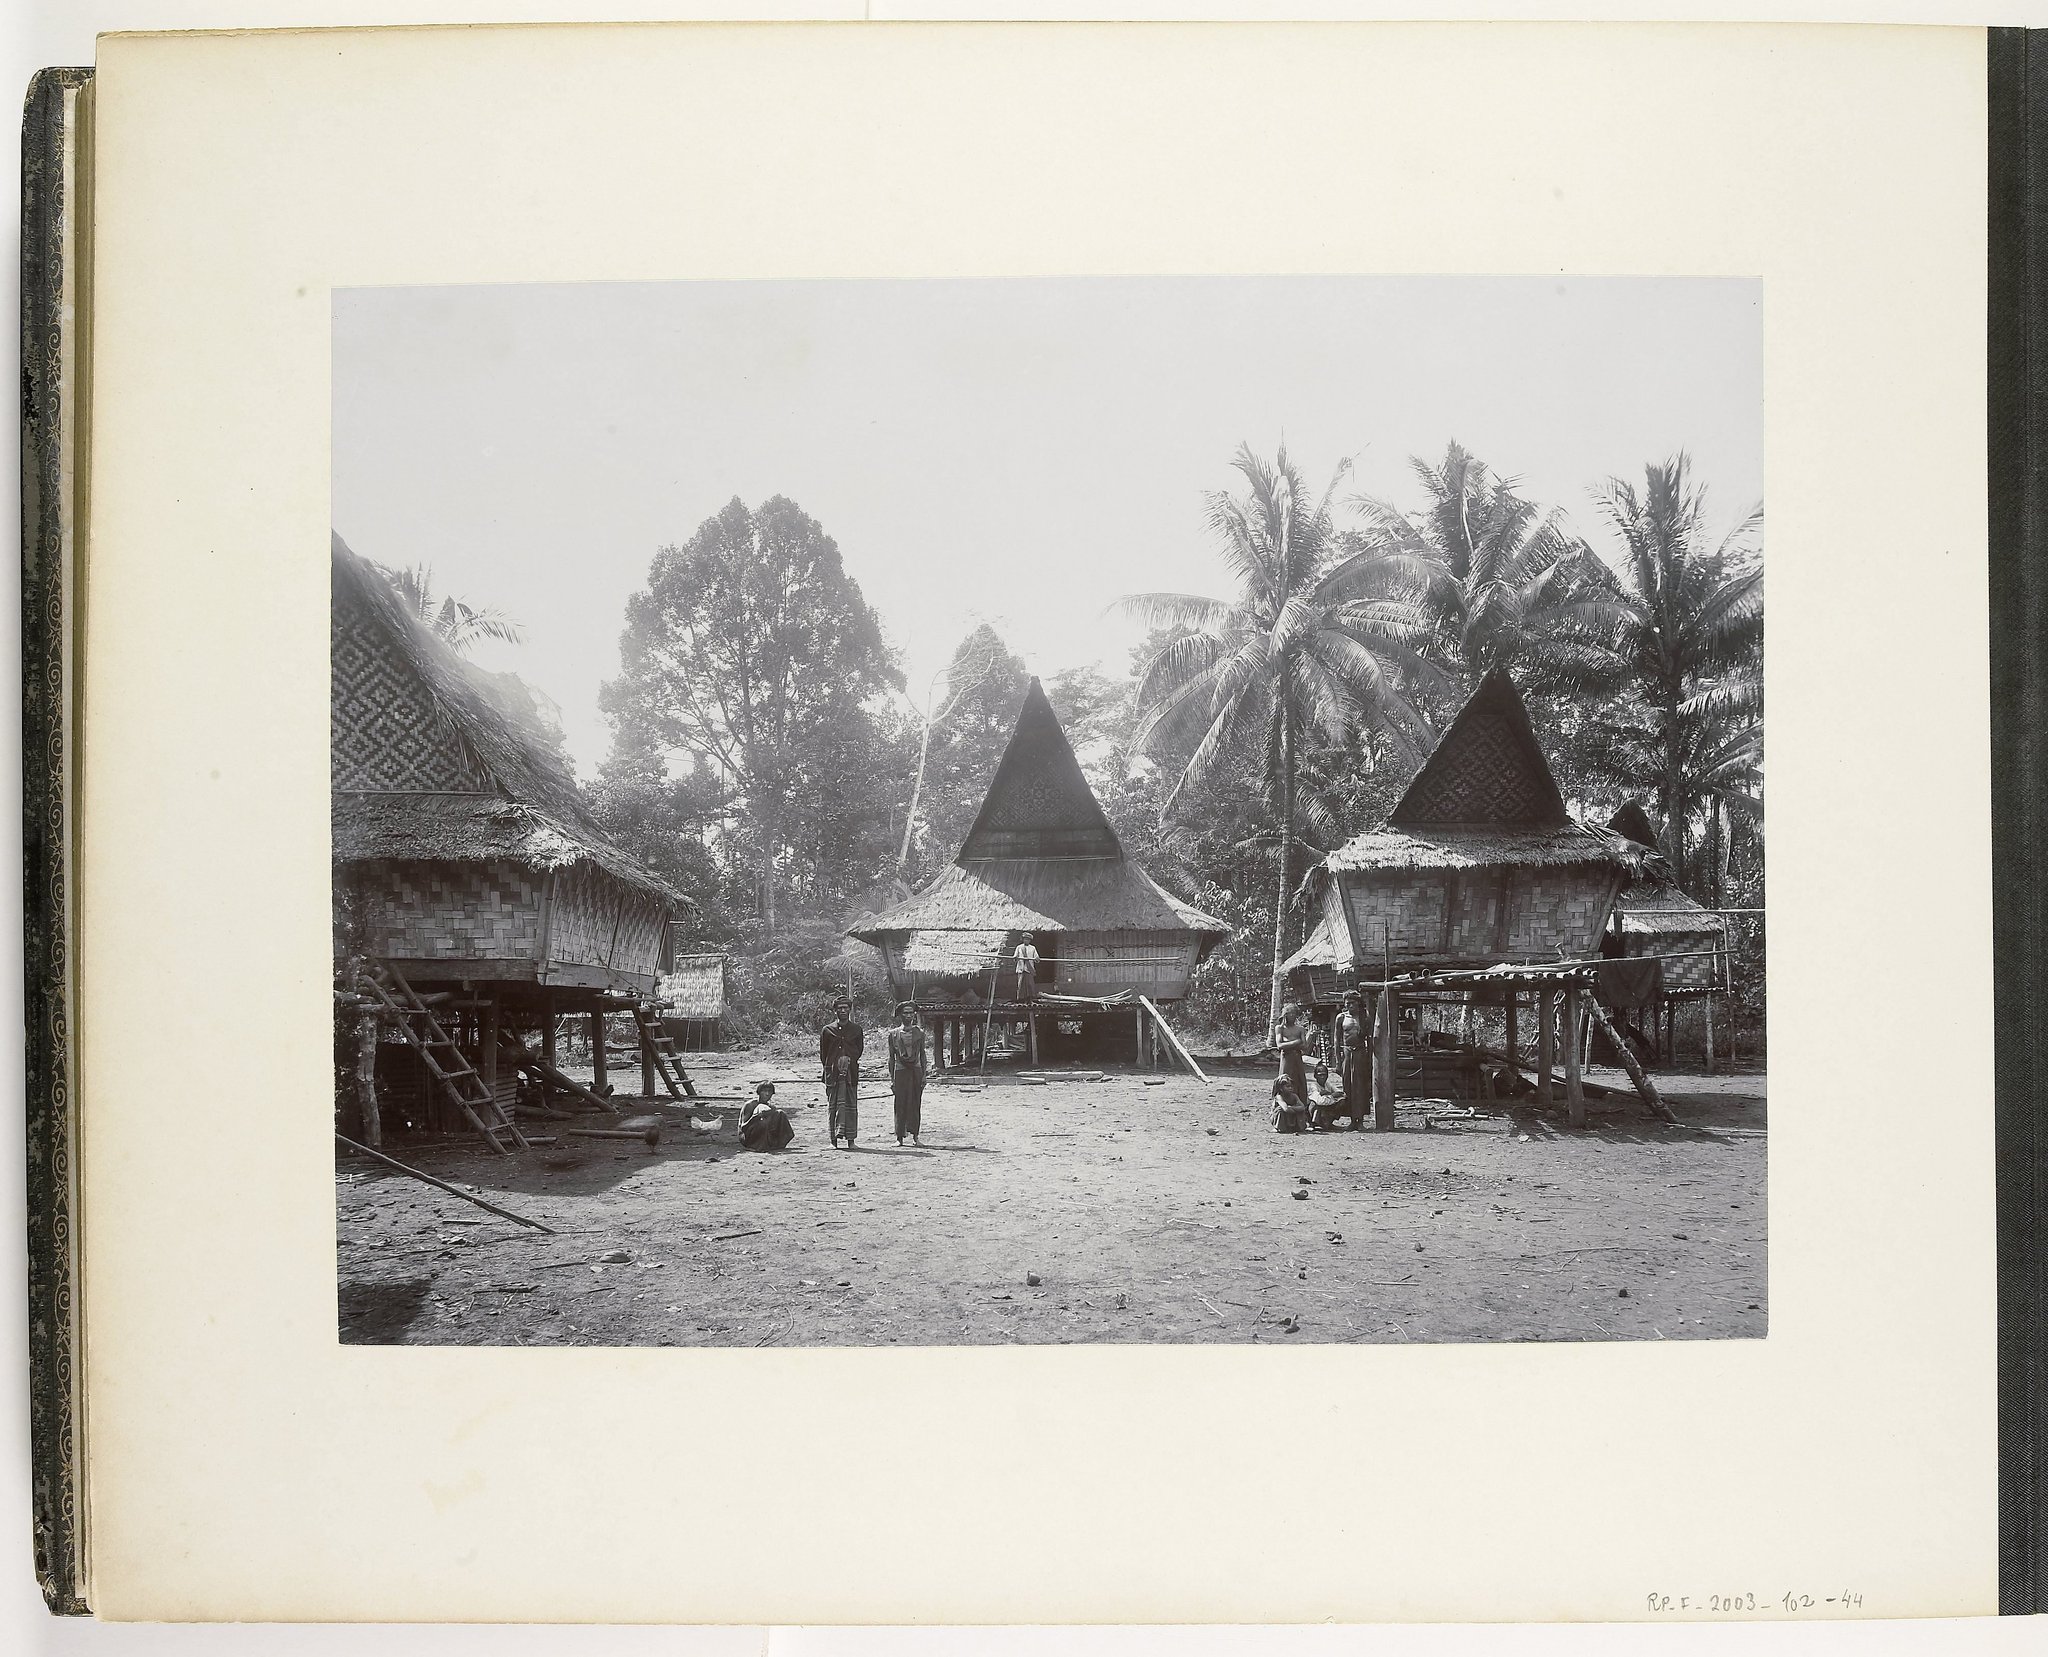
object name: photograph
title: Gezicht op Battak Kampong Bekiven, Sumatra (Battak Kampong Bakioen)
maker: carl j. kleingrothe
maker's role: fotograaf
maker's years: 1864-1925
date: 1885-1900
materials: photographic support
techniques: collodion silver print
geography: sumatra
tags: sumatra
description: Gezicht in het Batakdorp Bekiven. Dorpelingen poseren voor de karakteristieke woningen op palen. Onderdeel van het Sumatra fotoalbum van Paul en Lucie Sandel uit 1900.